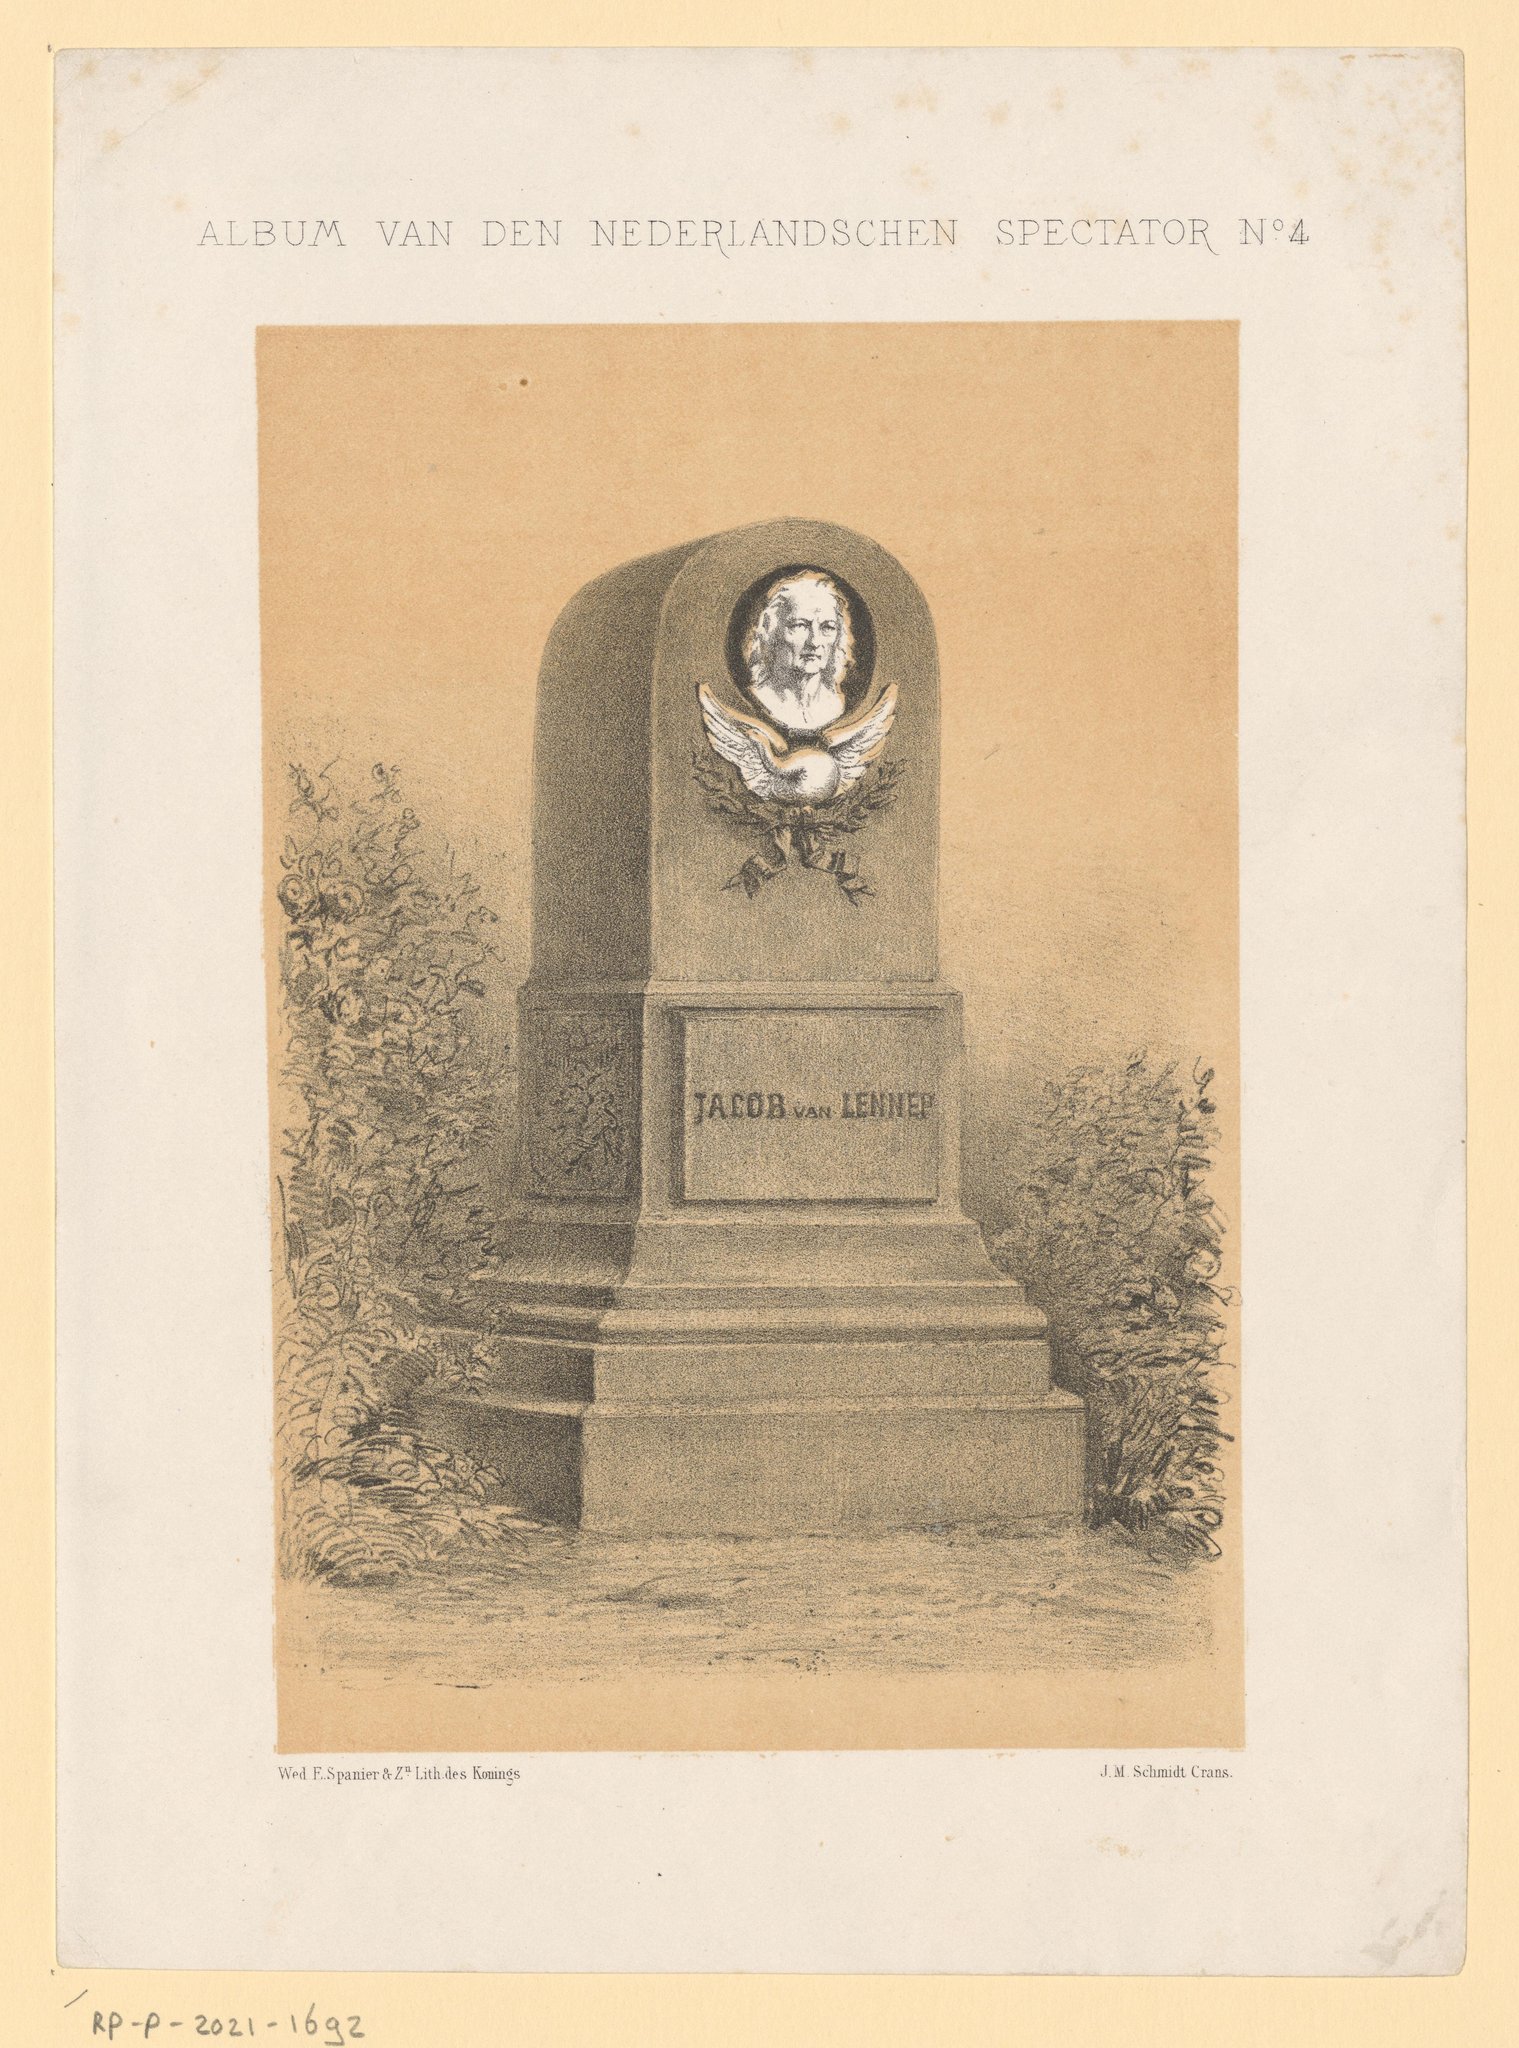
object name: print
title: Grafmonument voor Jacob van Lennep, 1869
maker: johan michaël schmidt crans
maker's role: draughtsman, print maker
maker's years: 1830-1907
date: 1869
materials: paper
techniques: tone lithography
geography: netherlands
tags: amsterdam, jacob van lennep, historical persons, portrait of a writer, grave-building, monumental tomb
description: Het grafmonument van Jacob van Lennep op het kerkhof te Oosterbeek (opgericht 1869), waar hij op 25 augustus 1868 overleed. Boven: Album van den Nederlandschen Spectator No. 4.